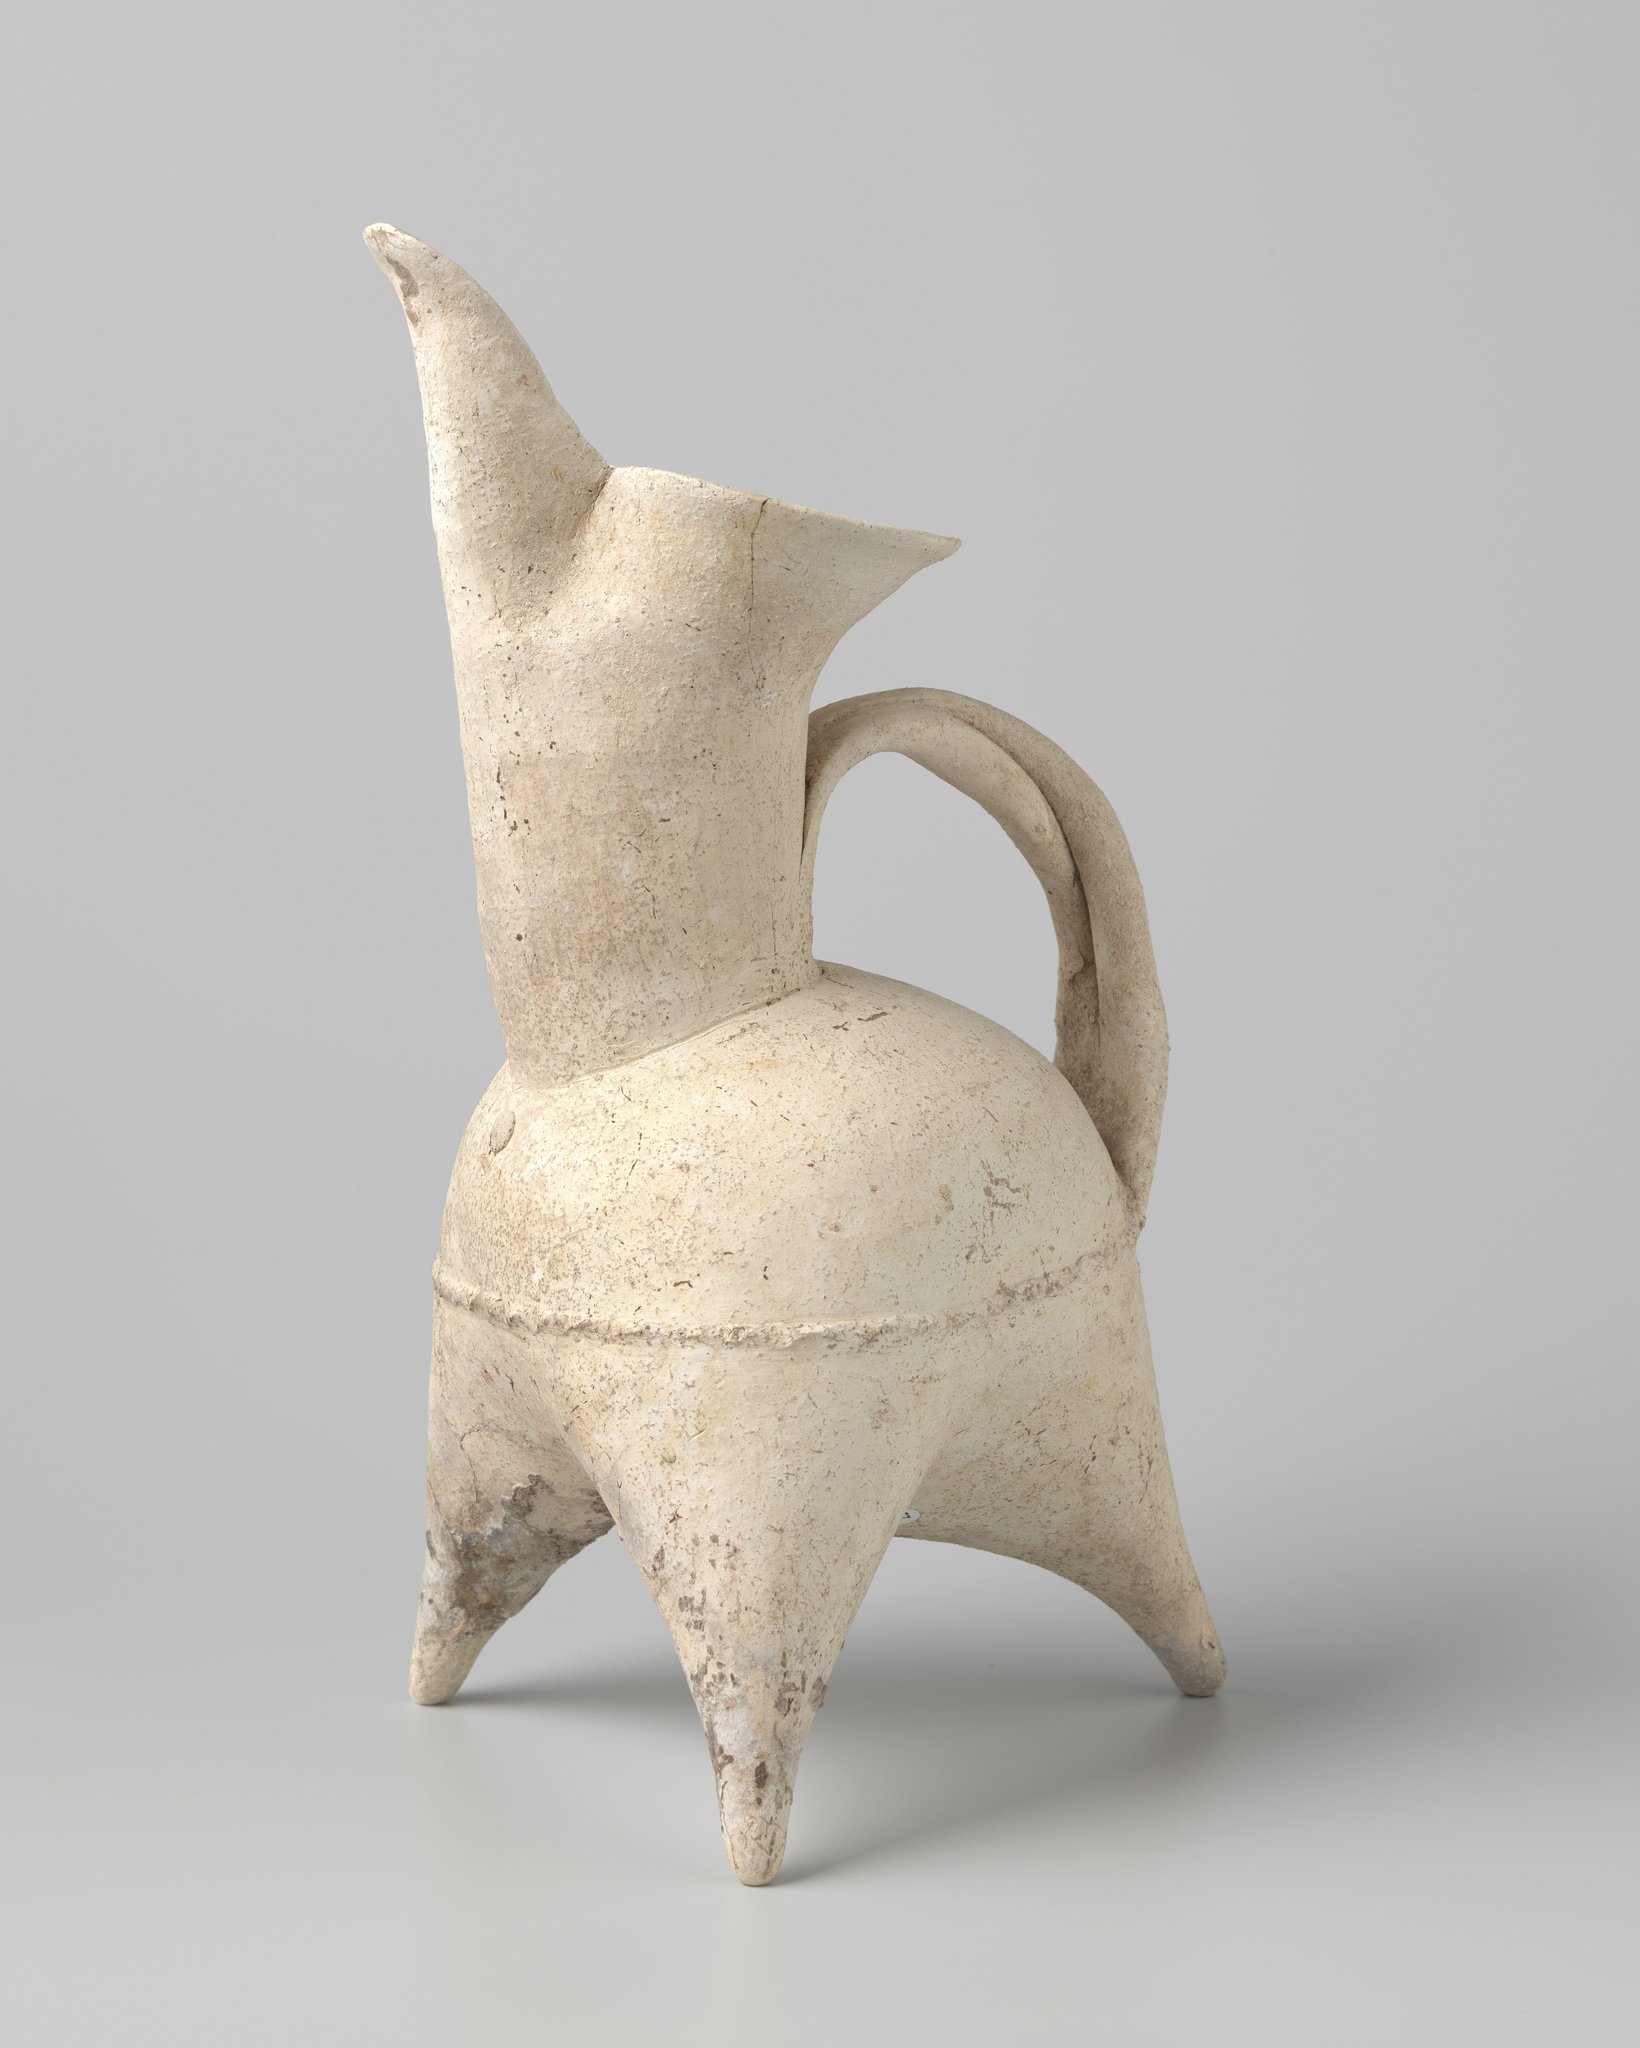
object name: ewer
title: Gui with a Curved Handle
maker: Anonymous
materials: ceramic, earthenware, stoneware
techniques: vitrification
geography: shandong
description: A gui is a type of ewer, with a spout, a handle, and three legs. The elongated neck and pointed spout of this gui are reminiscent of a bird’s beak. The handle is shaped like a twisted rope. The vessel’s three wide and hollow legs made it possible to bake the earthenware directly on the fire.